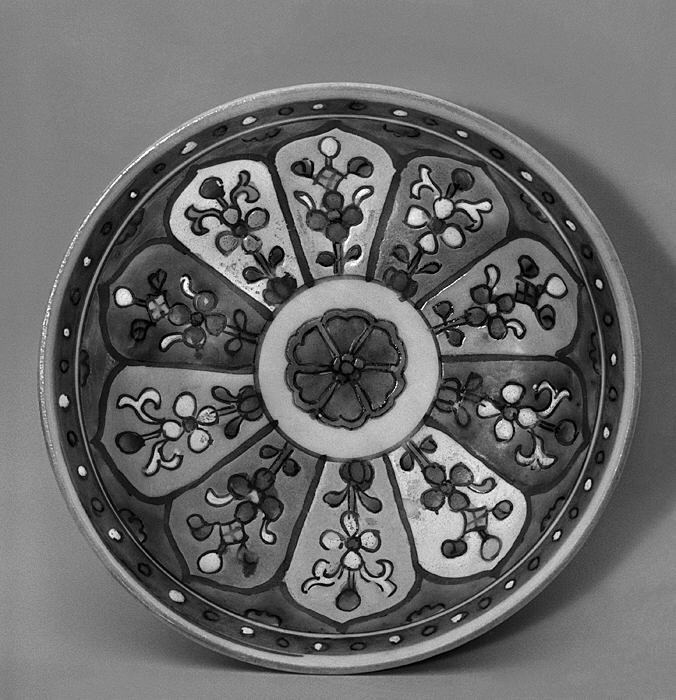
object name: dish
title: Dish with floral pattern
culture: chinese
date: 1801-1900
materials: enamel, porcelain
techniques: overglaze, painting, polychrome